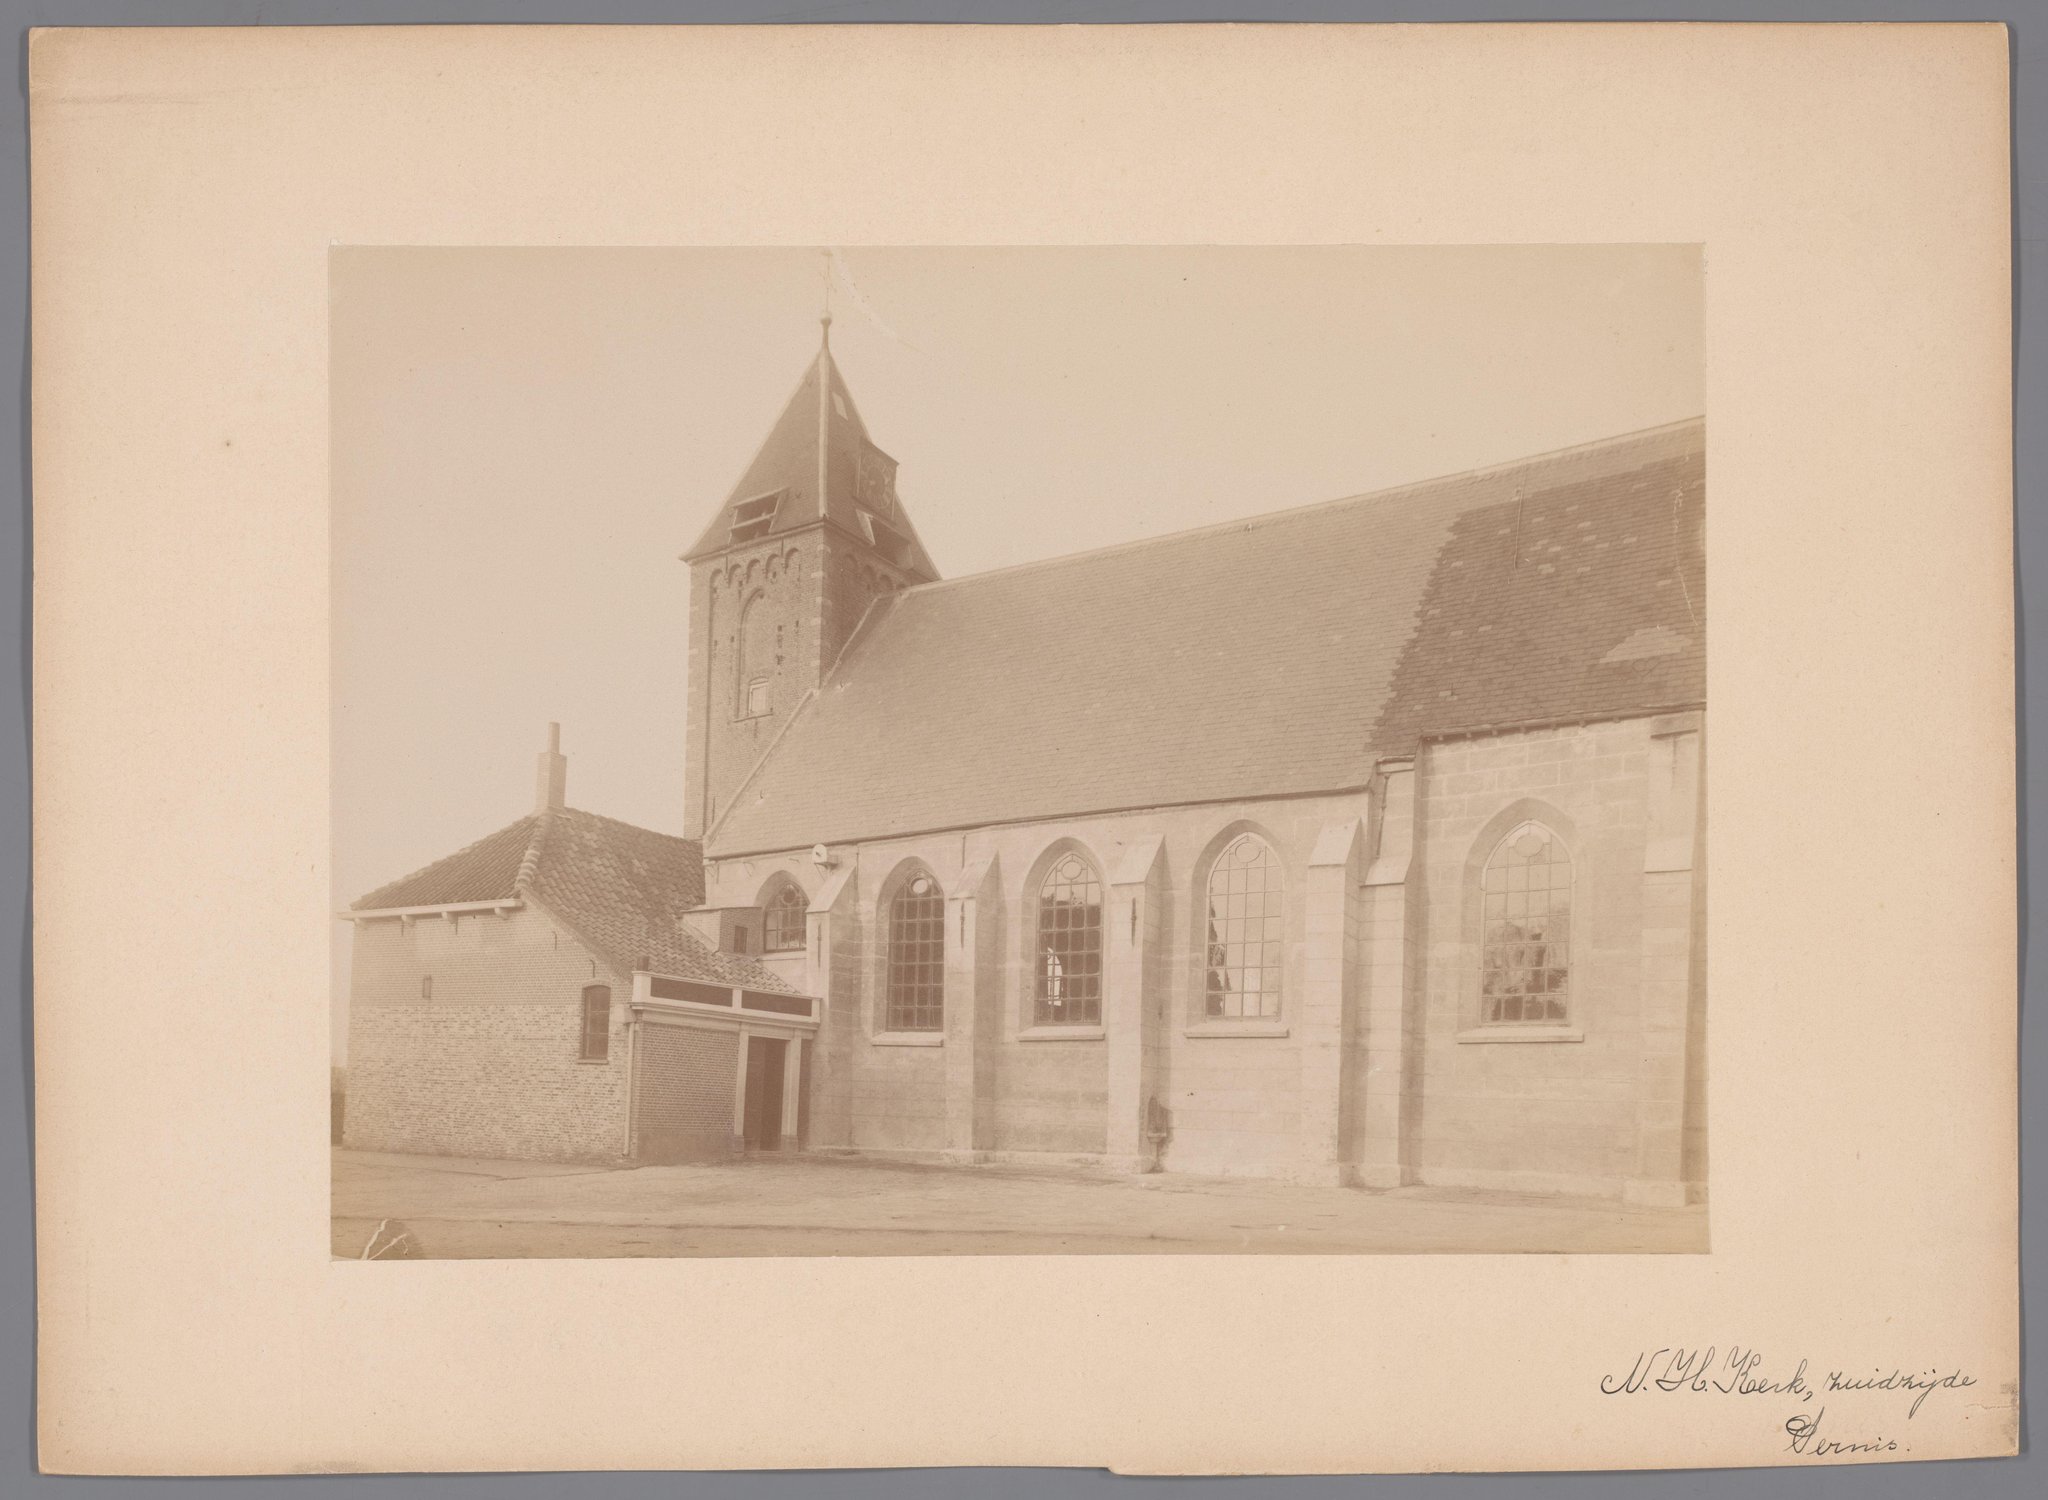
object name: photograph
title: Zuidzijde van de Hervormde Kerk te Pernis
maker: anoniem (monumentenzorg)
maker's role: fotograaf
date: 1890-1920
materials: cardboard, photographic support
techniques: albumen print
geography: pernis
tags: church (exterior)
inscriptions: annotation: ‘Pernis/ N.H. Kerk/ Z zijde’, annotation: ‘N.H. Kerk, zuidzijde/ Pernis’